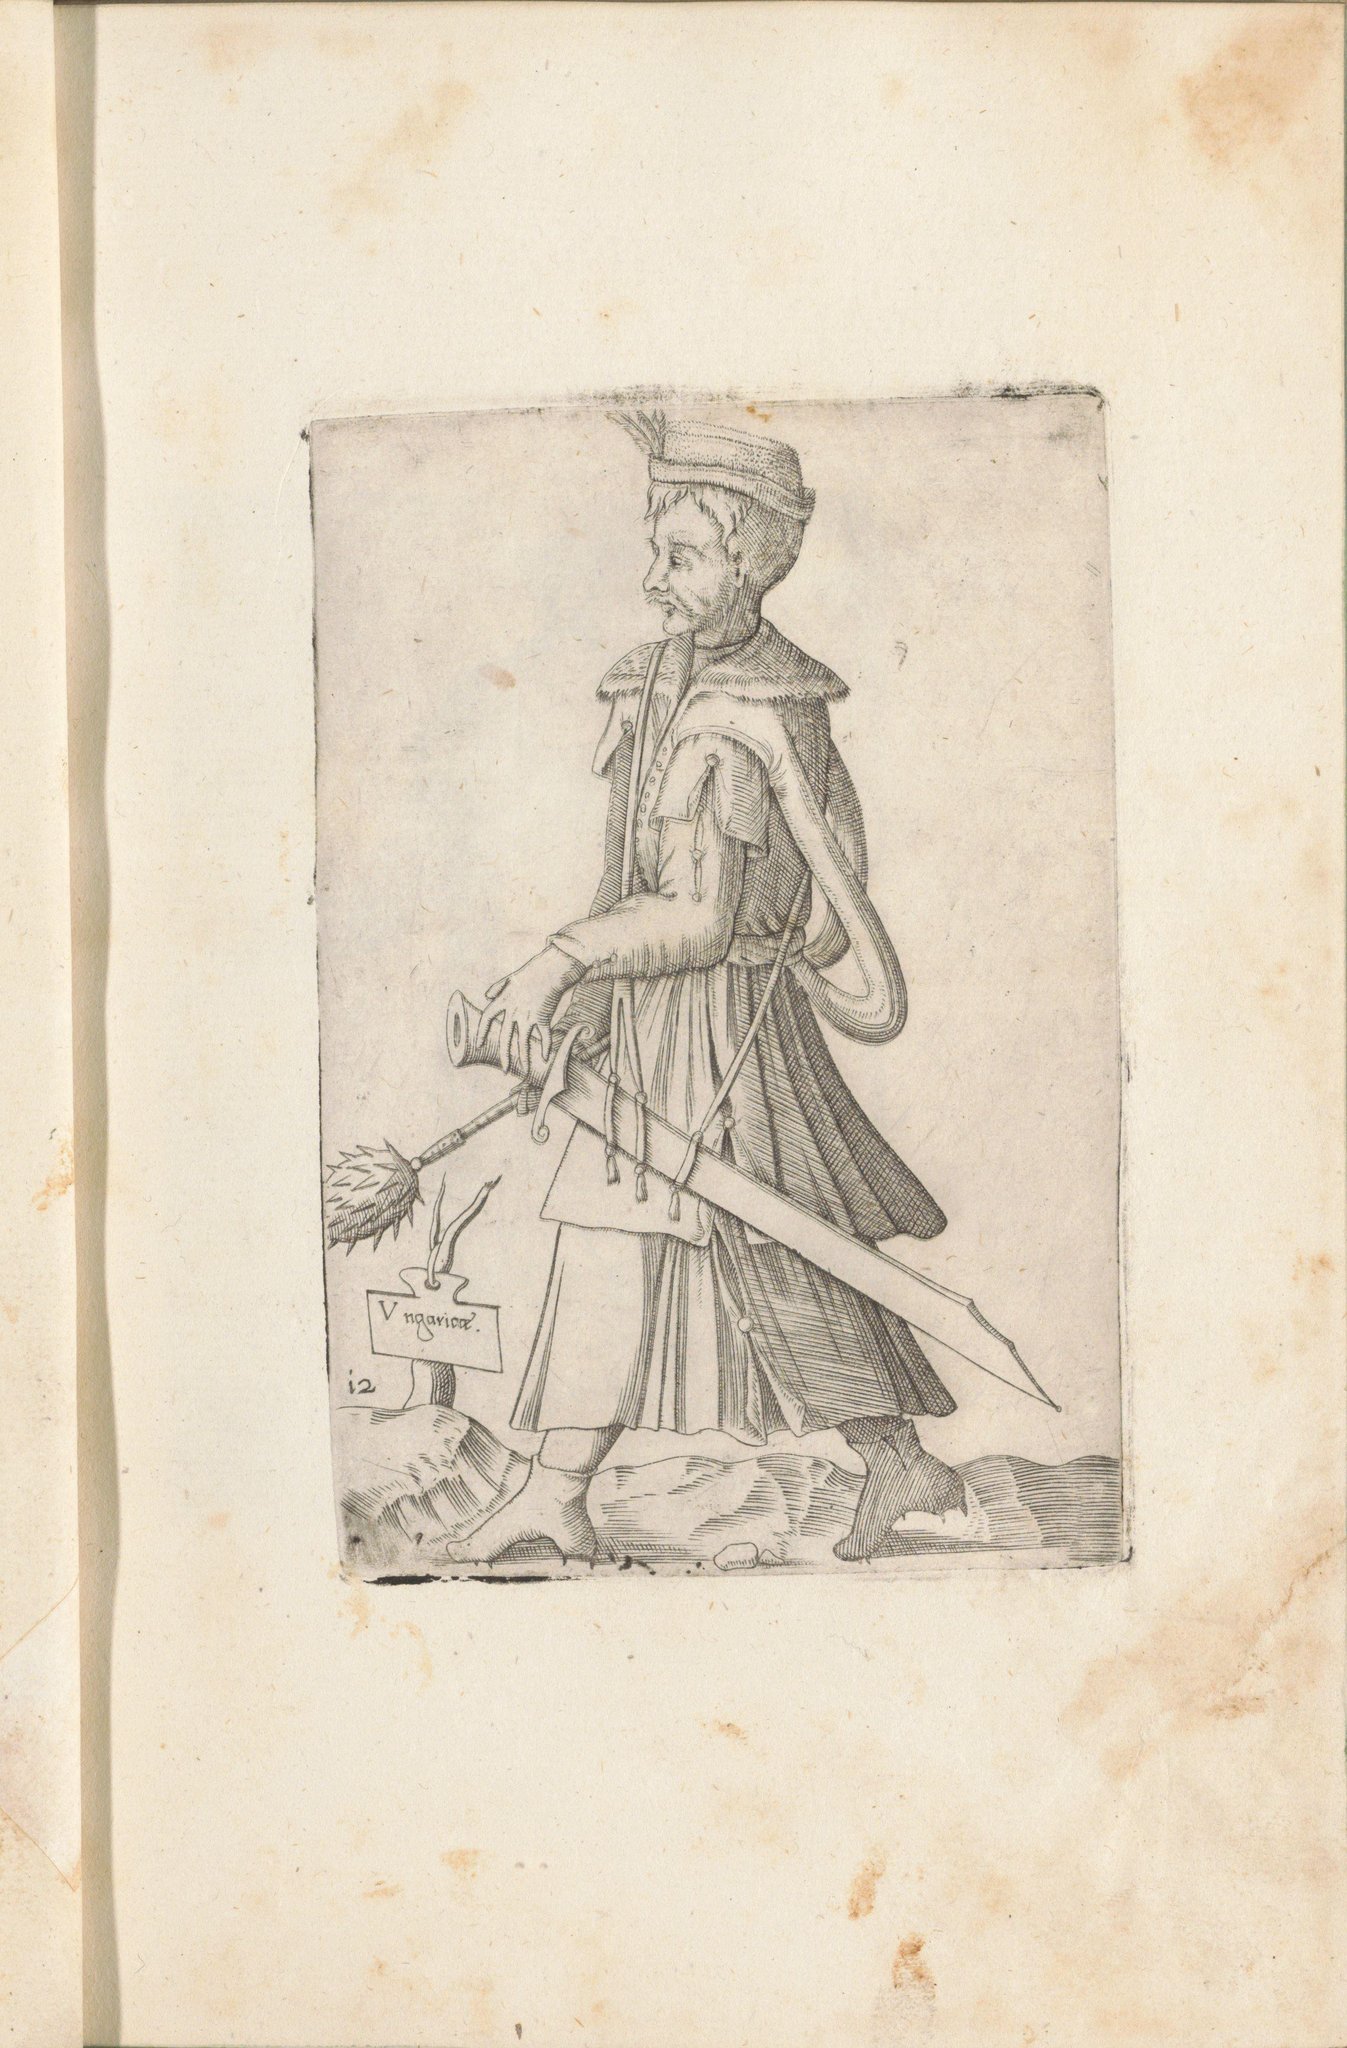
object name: costume print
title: Omnium fere gentium nostrae aetatis habitus, nunquam ante hac aediti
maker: ferando bertelli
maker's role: print maker, publisher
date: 1569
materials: paper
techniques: engraving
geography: venice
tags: fashion plates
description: Hongaarse krijgsman. Onderdeel van het kostuumboek getiteld 'Omnium fere gentium nostrae aetatis habitus, nunquam ante hac aediti', Venetië 1569. Heruitgave uit 1569 van de eerste editie uit 1563.